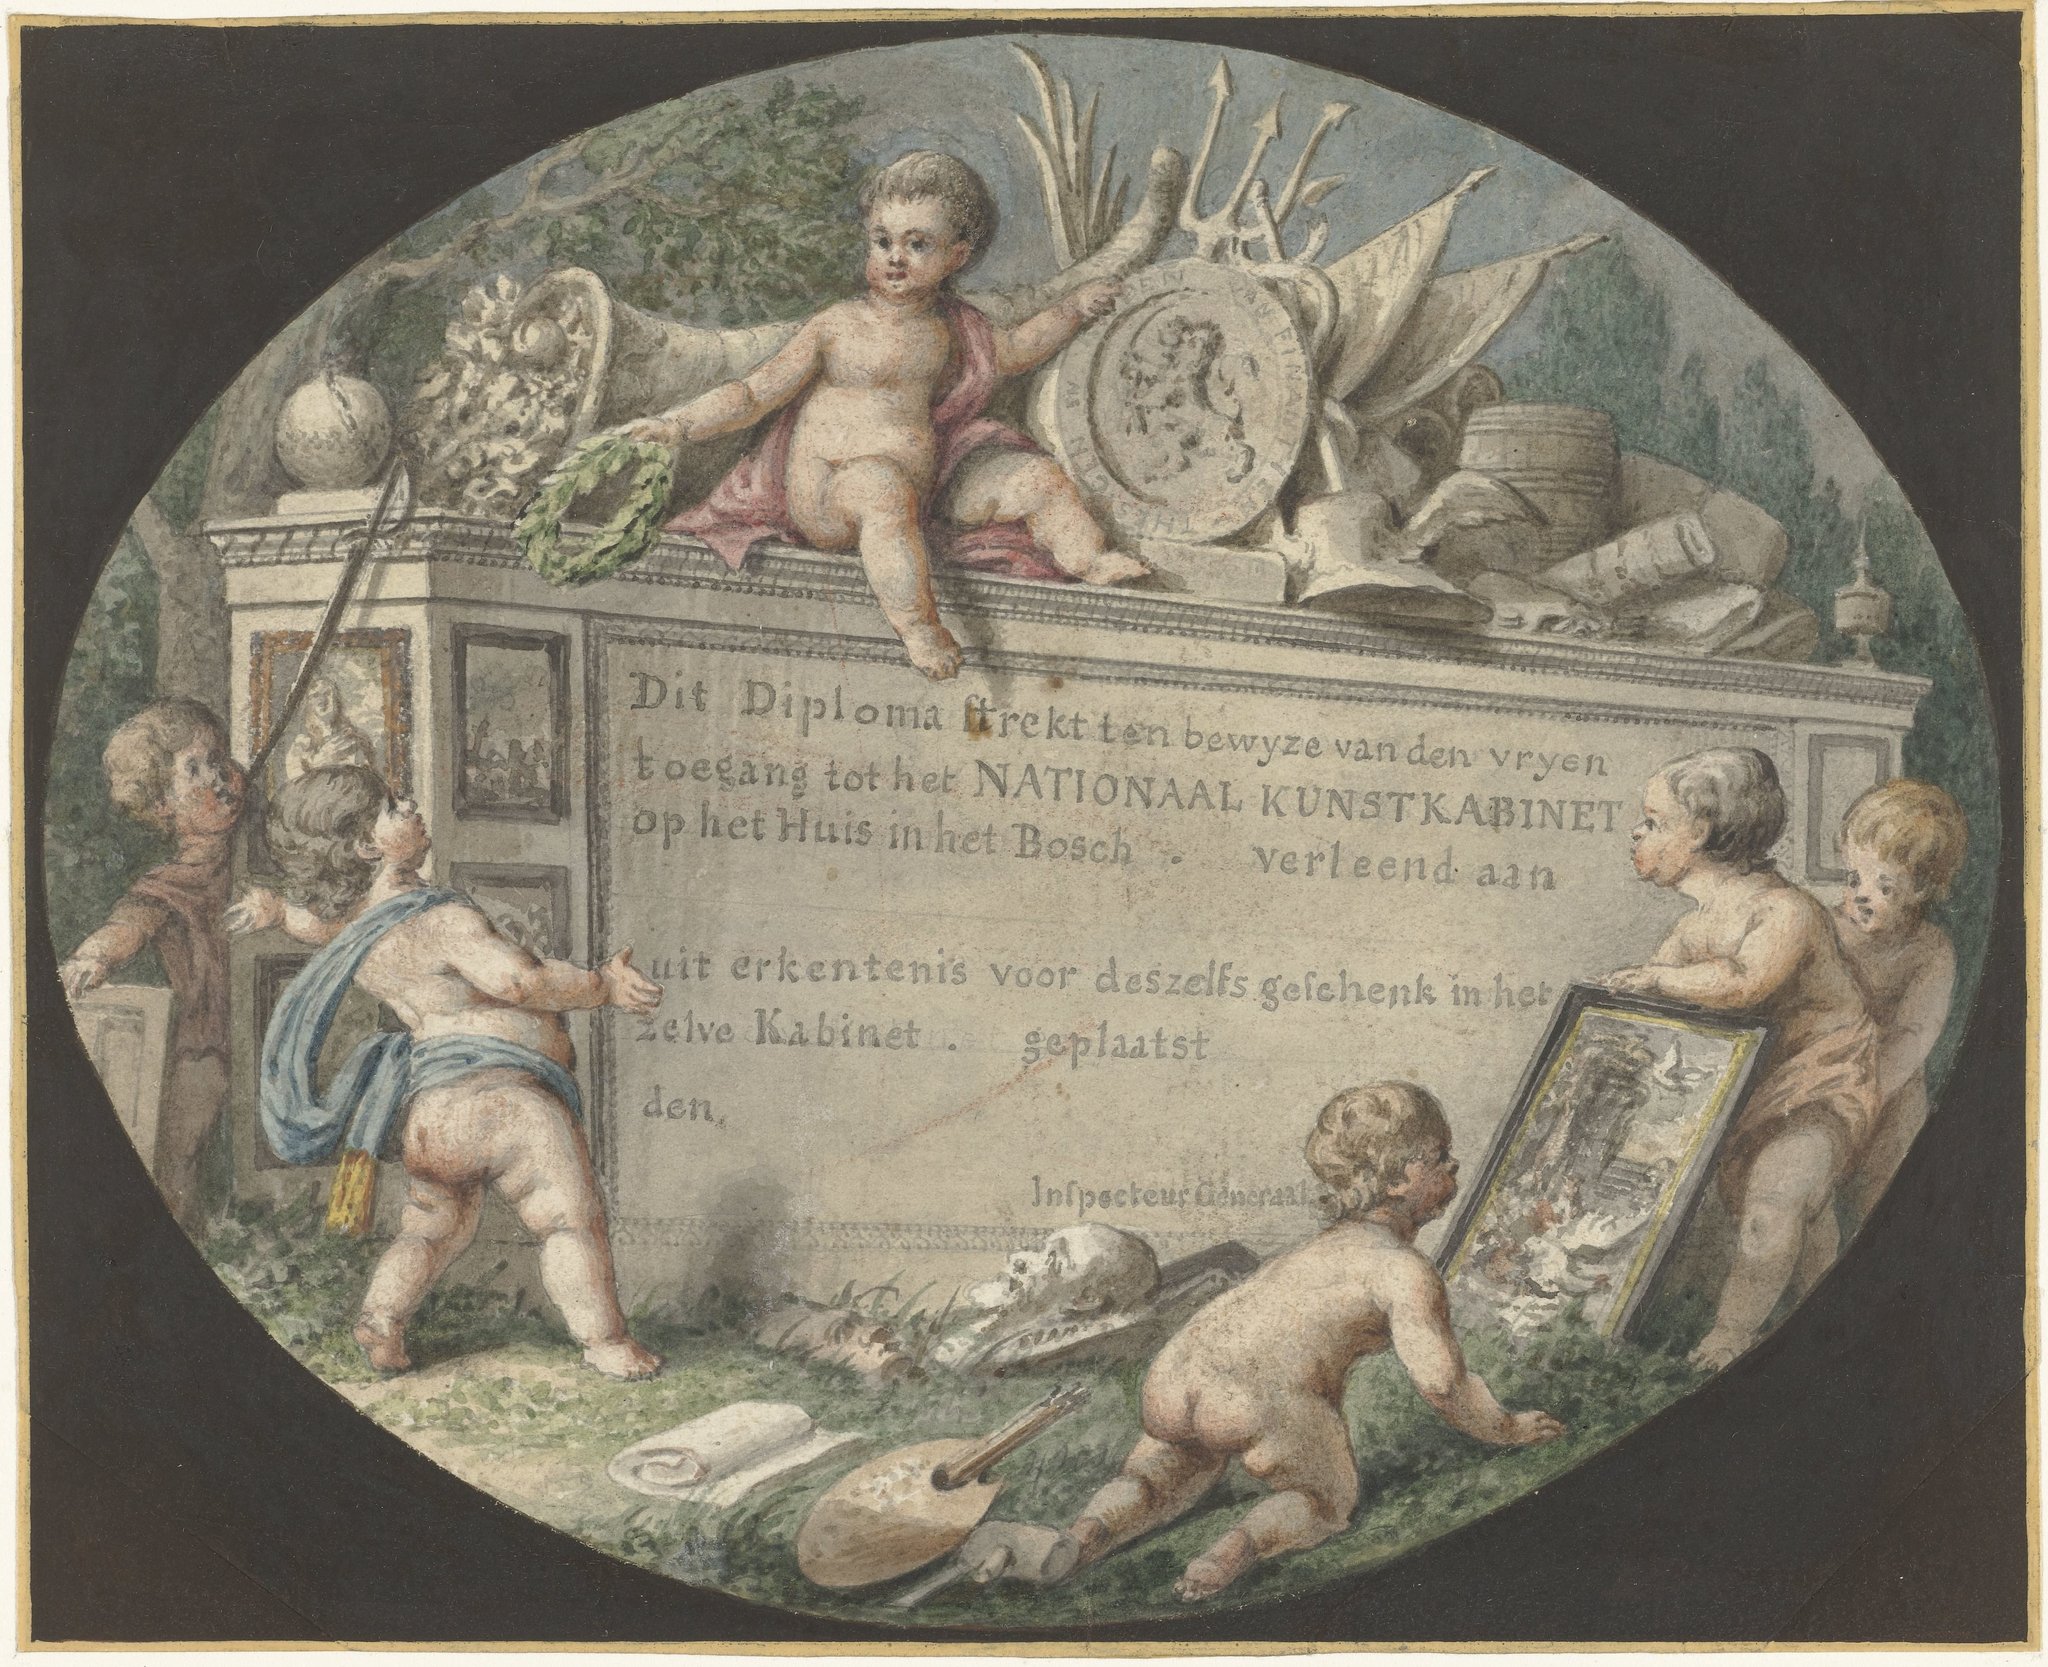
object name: drawing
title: Ontwerp van een toegangsbewijs voor het Nationaal Kunstkabinet op het Huis ten Bosch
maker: jan gerard waldorp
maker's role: draughtsman, print maker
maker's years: 1740-1808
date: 1800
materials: ink, paper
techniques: brush, pen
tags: art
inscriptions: inscription: ‘Dit Diploma strekt ten bewyze van den vryen toegang tot het NATIONAAL KUNSTKABINET op het Huis in het Bosch verleend aan uit erkentenis voor deszelfs geschenk in hetzelve Kabinet geplaatst (...)’